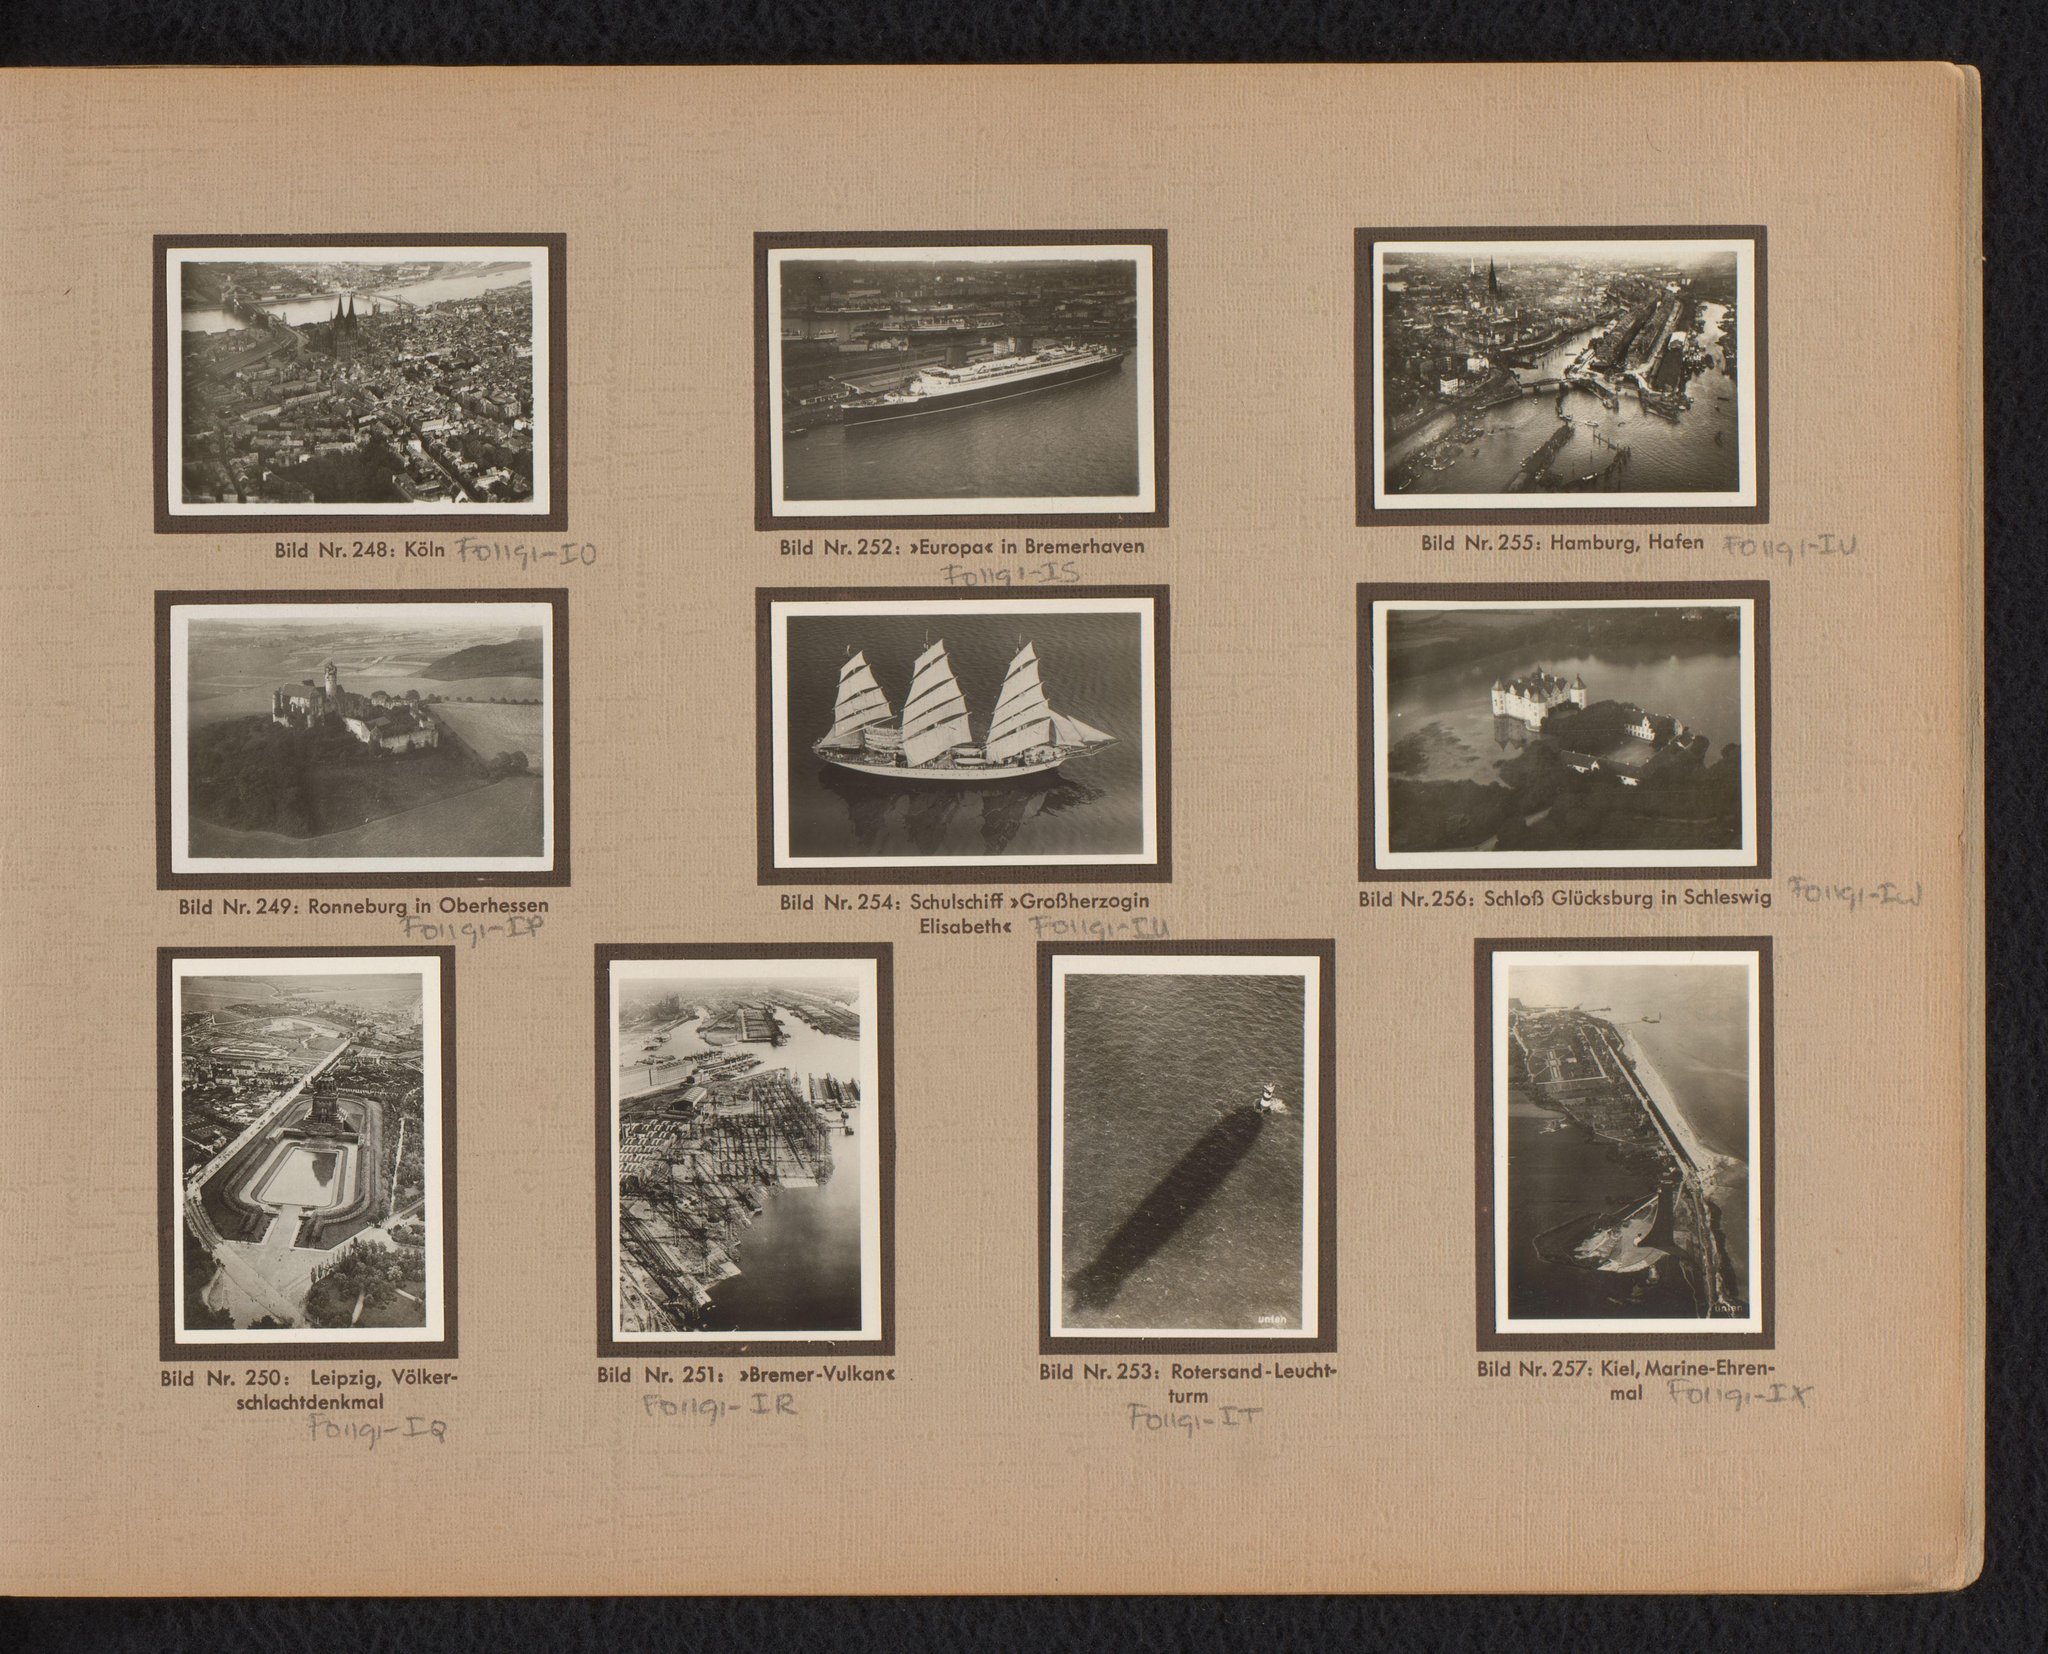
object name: album leaf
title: Uitzichten over Duitsland tijdens een vlucht naar Egypte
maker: Anonymous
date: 1930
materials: paper, photographic support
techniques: gelatin silver print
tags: city-view, and landscape with man-made constructions, castle, landscapes with waters, waterscapes, seascapes (in the temperate zone), ships (in general), cologne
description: Tien foto's van Duitsland, gemaakt tijdens een vlucht naar Egypte, waaronder gezichten op Keulen, de haven van Hamburg, Bremerhaven, Schloss Glücksburg en het Völkerschlachtdenkmal te Leipzig. Alle foto's zijn voorzien van een nummer en titel. Deze pagina maakt deel uit van een album.